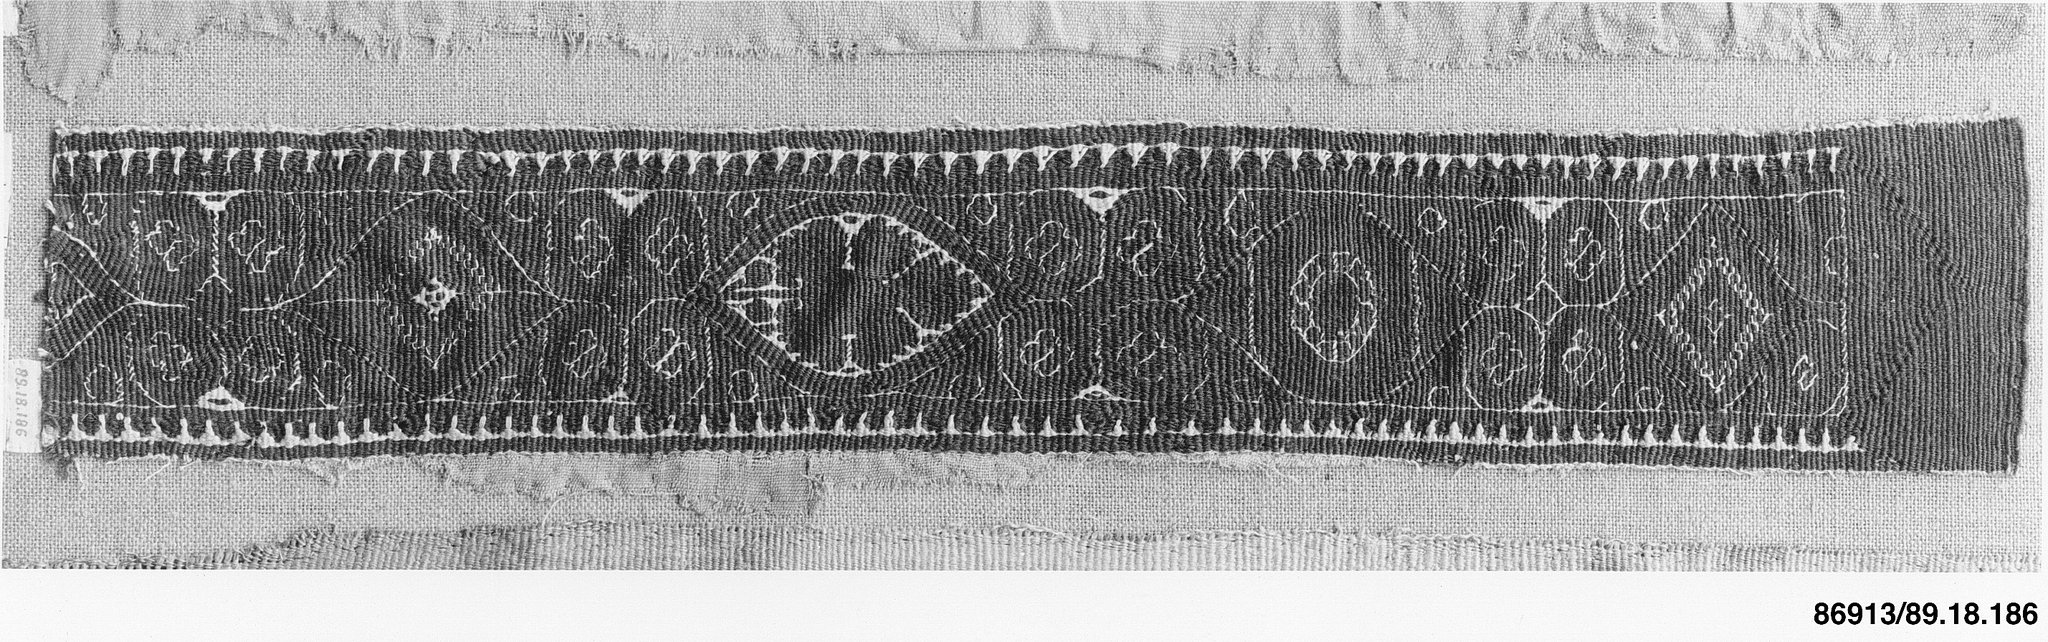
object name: textile fragment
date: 201-400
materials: linen, wool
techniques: weave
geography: egypt